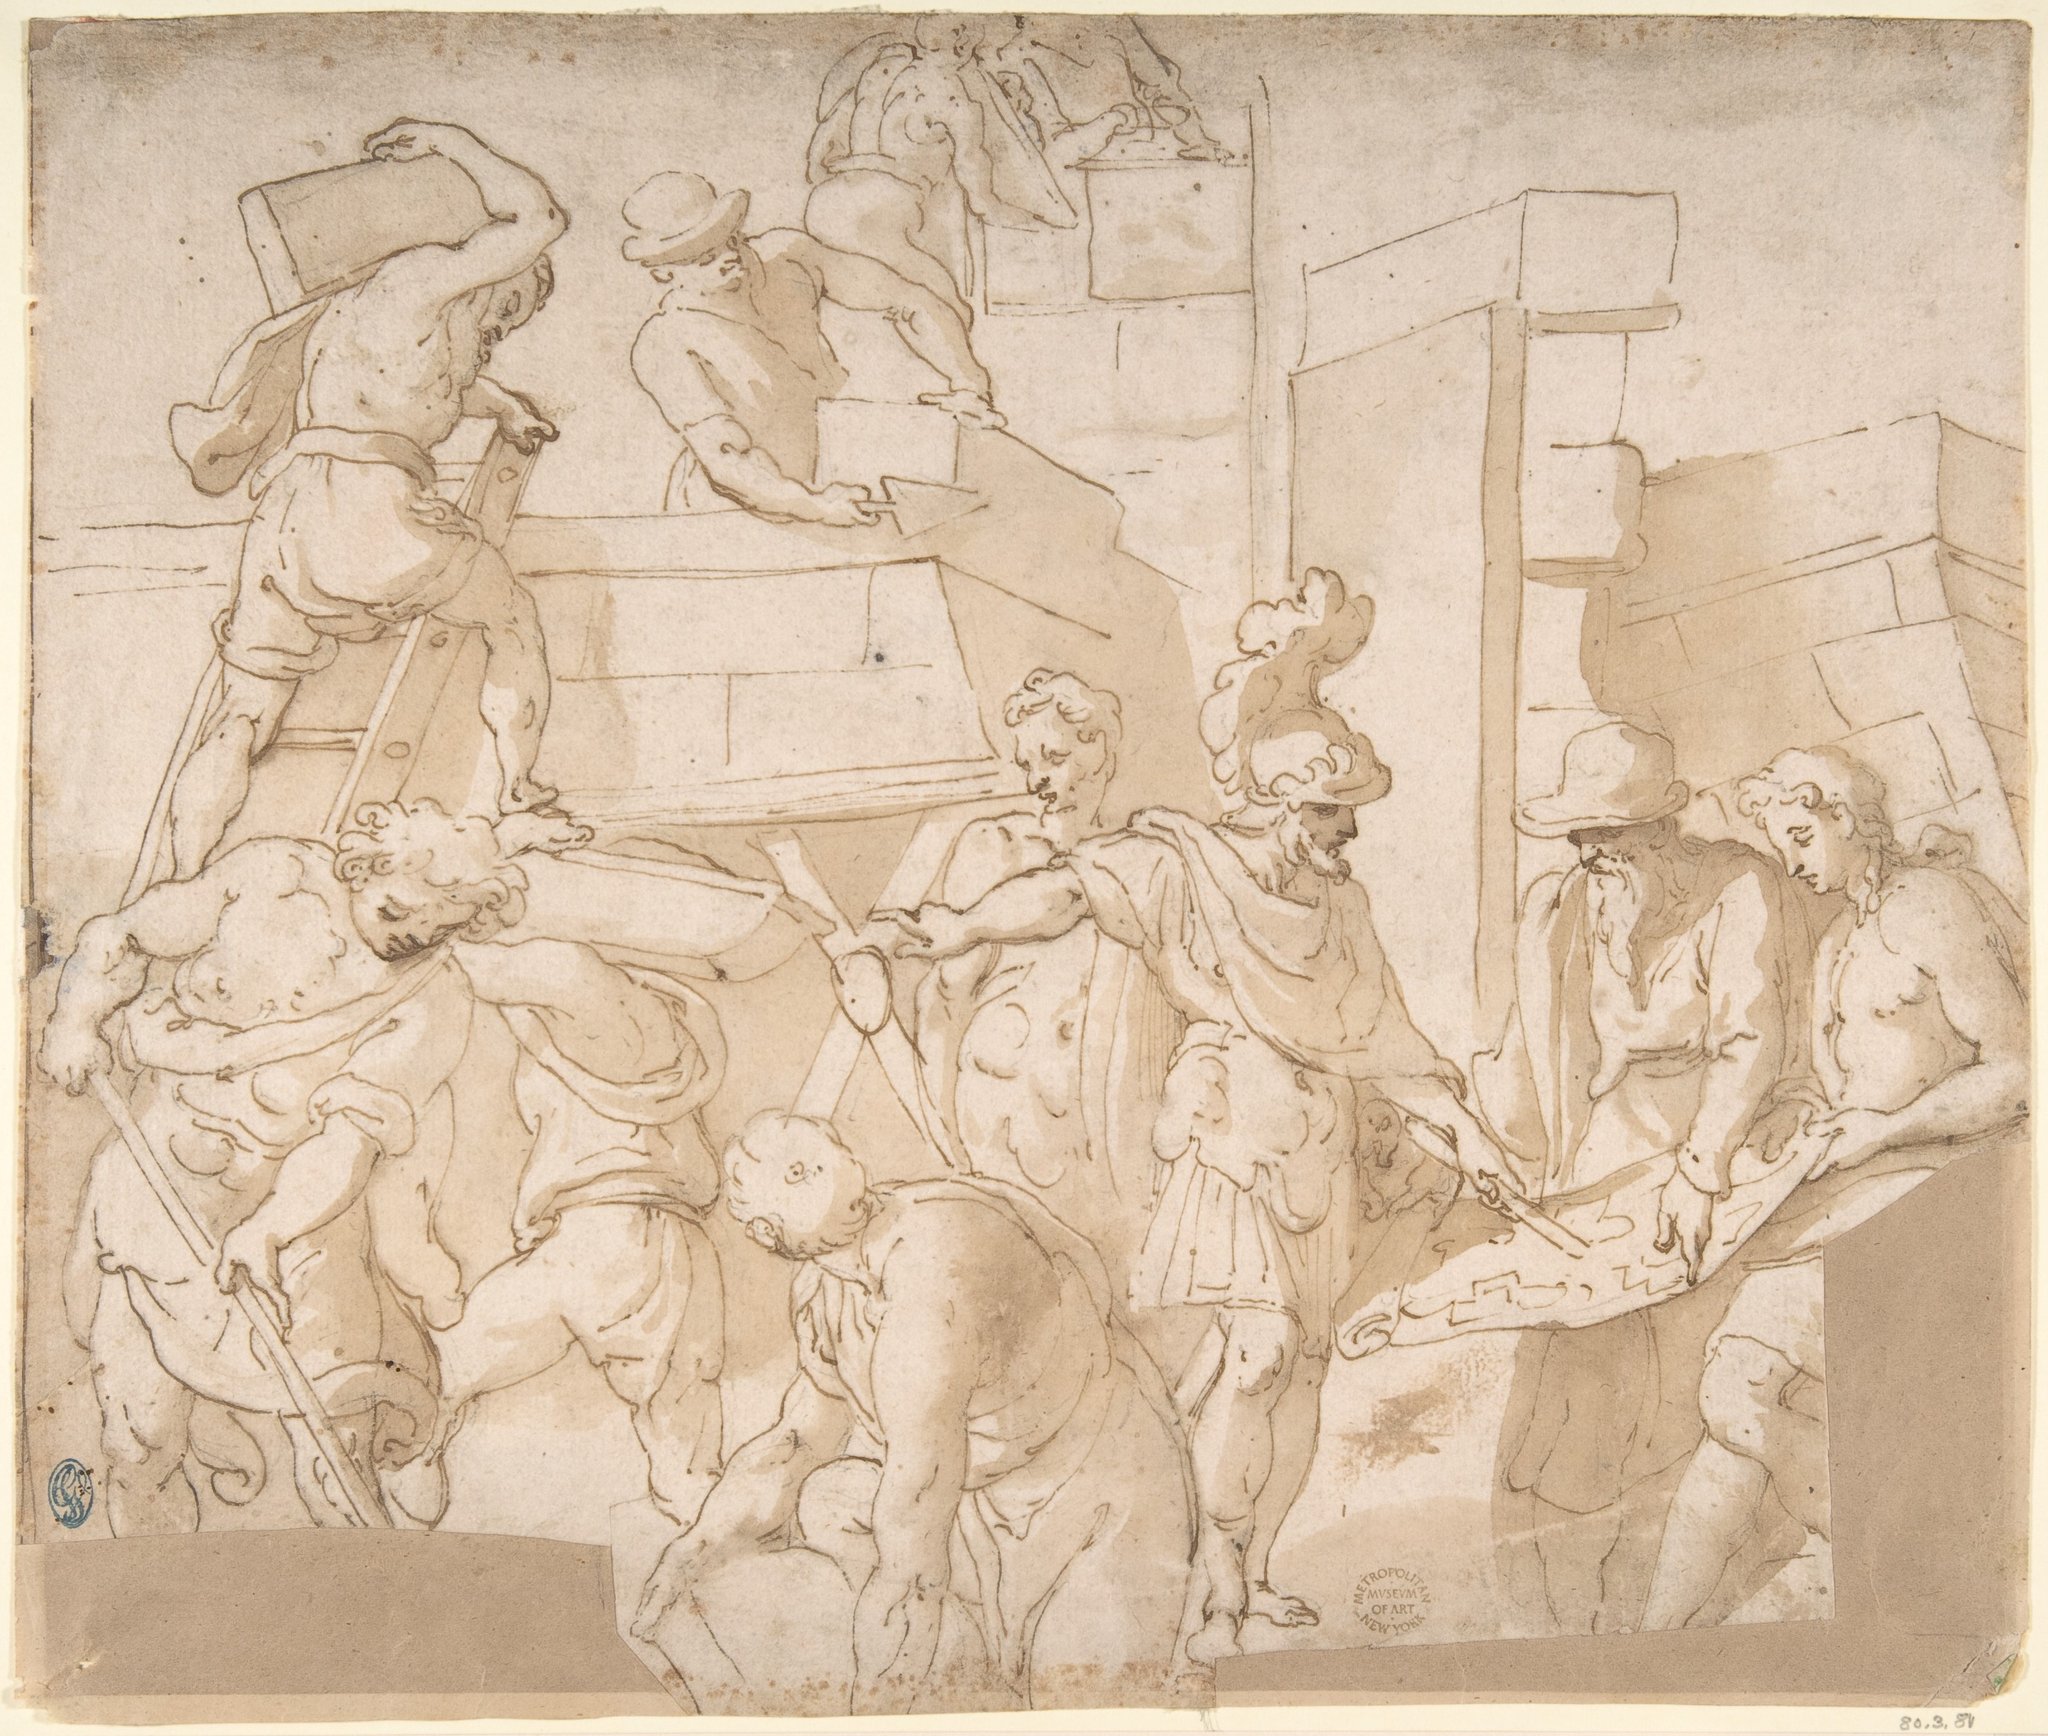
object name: drawing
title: Building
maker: cesare nebbia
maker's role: artist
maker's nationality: italian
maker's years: 1536-1614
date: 1536-1614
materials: ink, drawing material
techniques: brush, pen, wash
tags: buildings,men,ladders